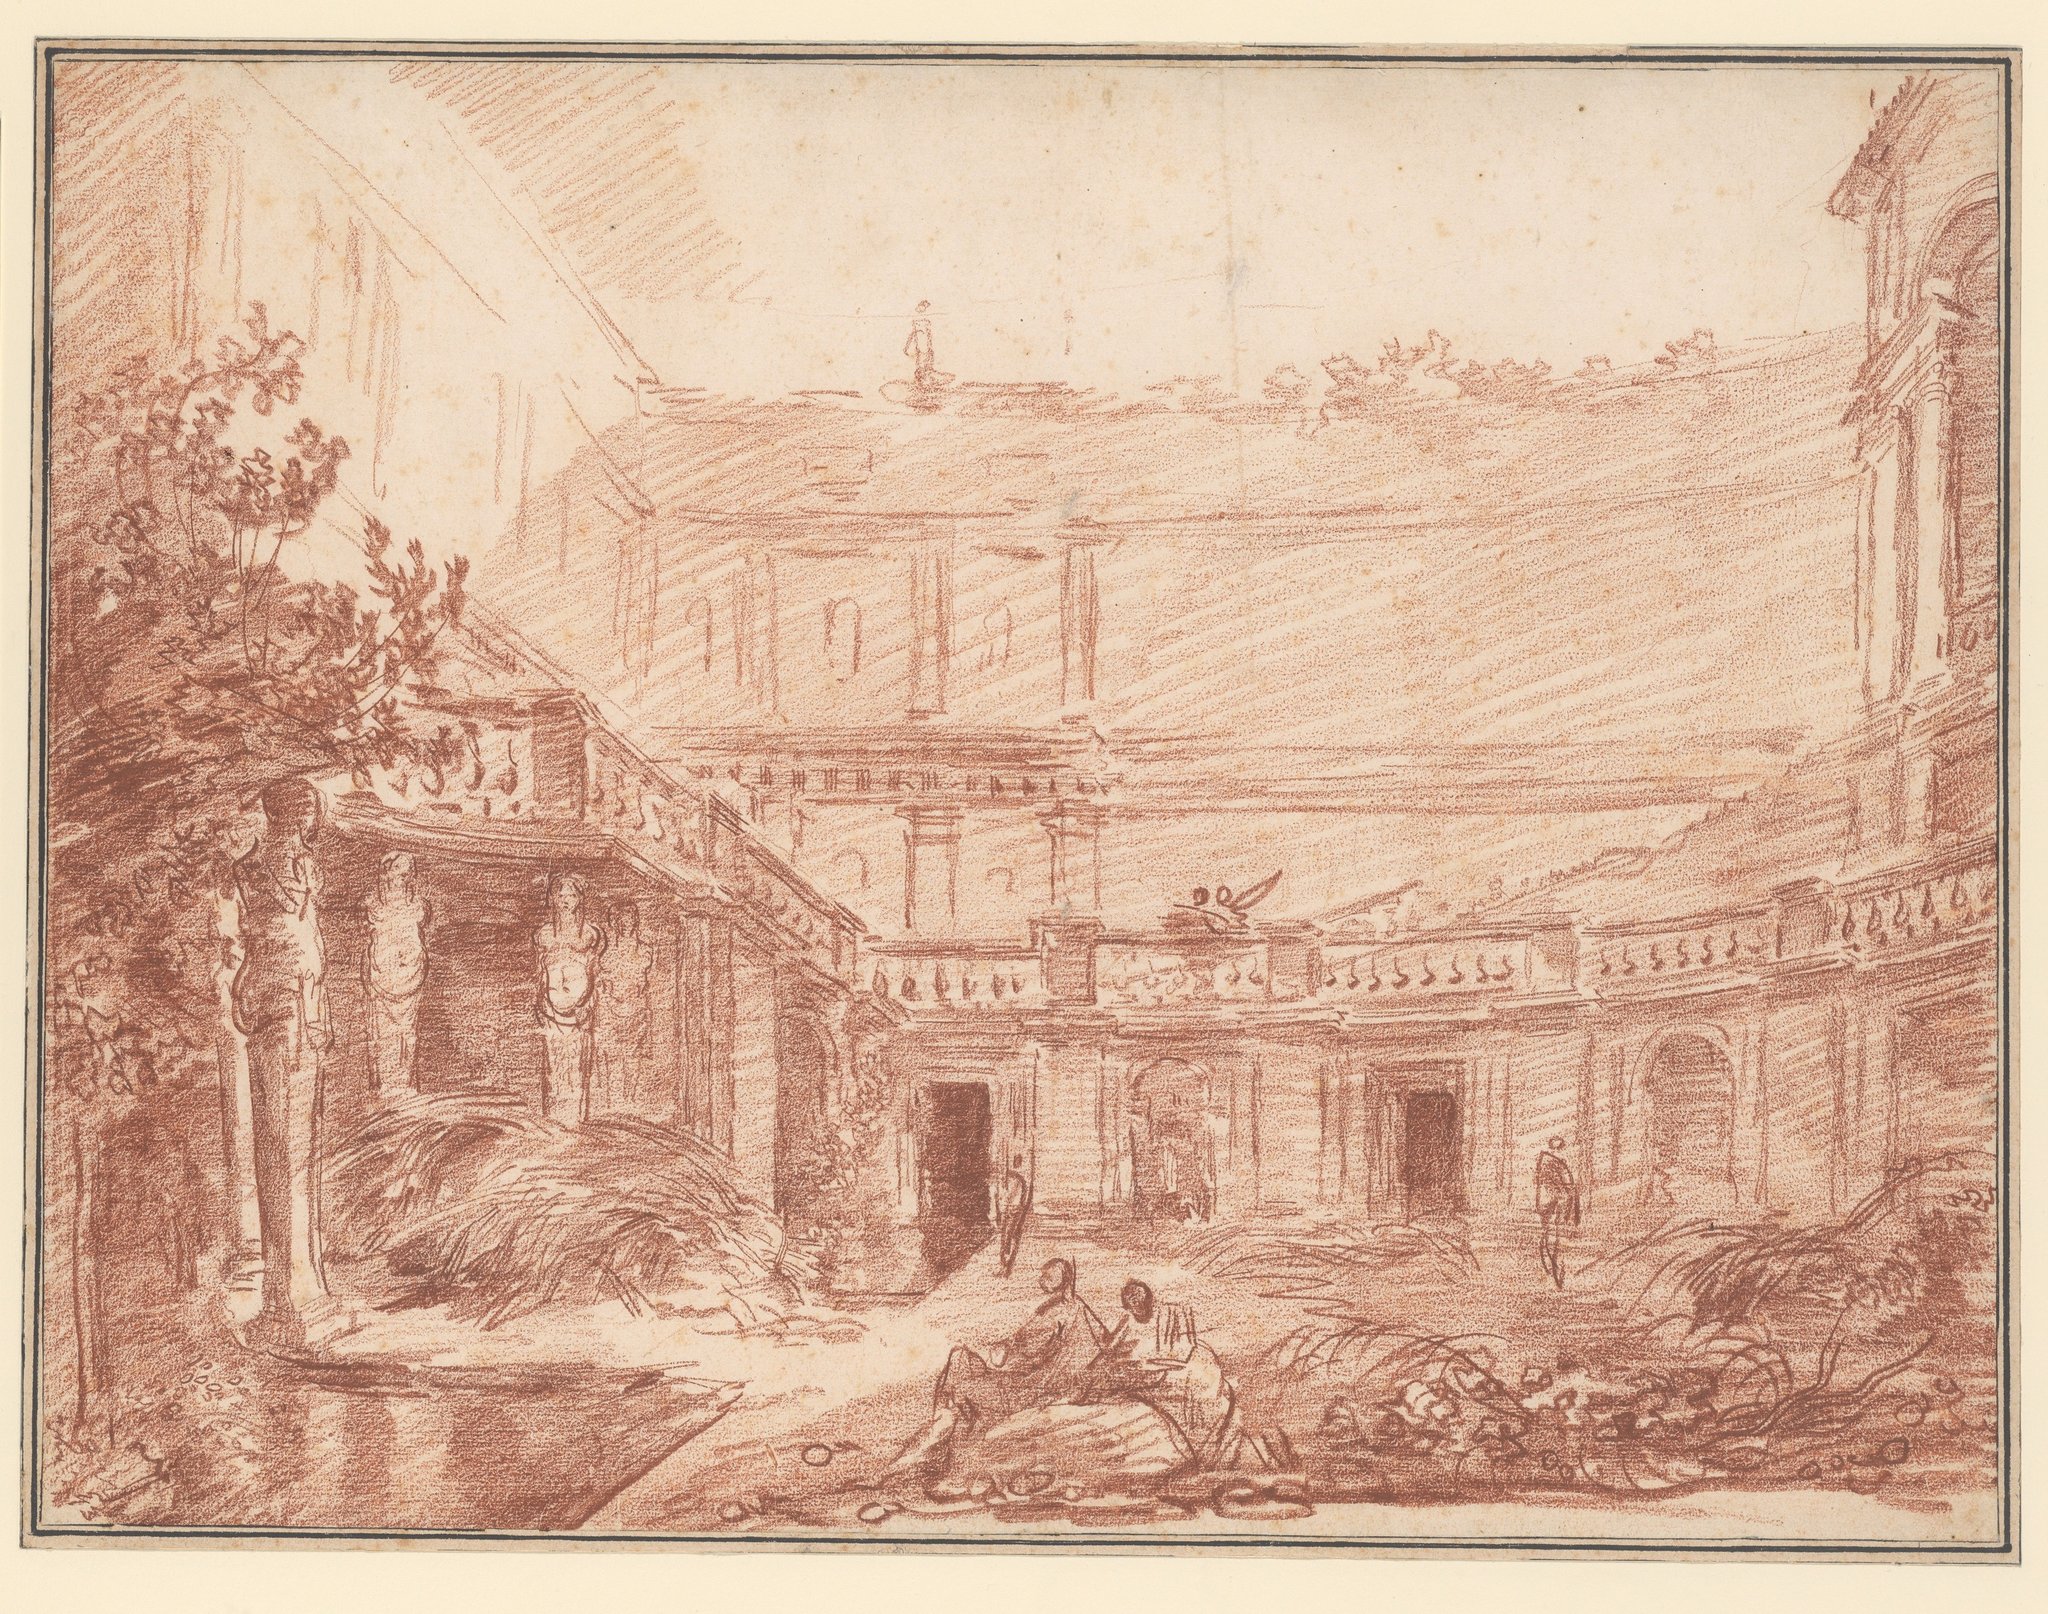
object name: drawing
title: The Nymphaeum of the Villa di Papa Giulio, Rome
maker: hubert robert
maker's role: artist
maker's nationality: french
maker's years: 1733-1808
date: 1761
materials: chalk, ink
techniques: pen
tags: buildings,rome